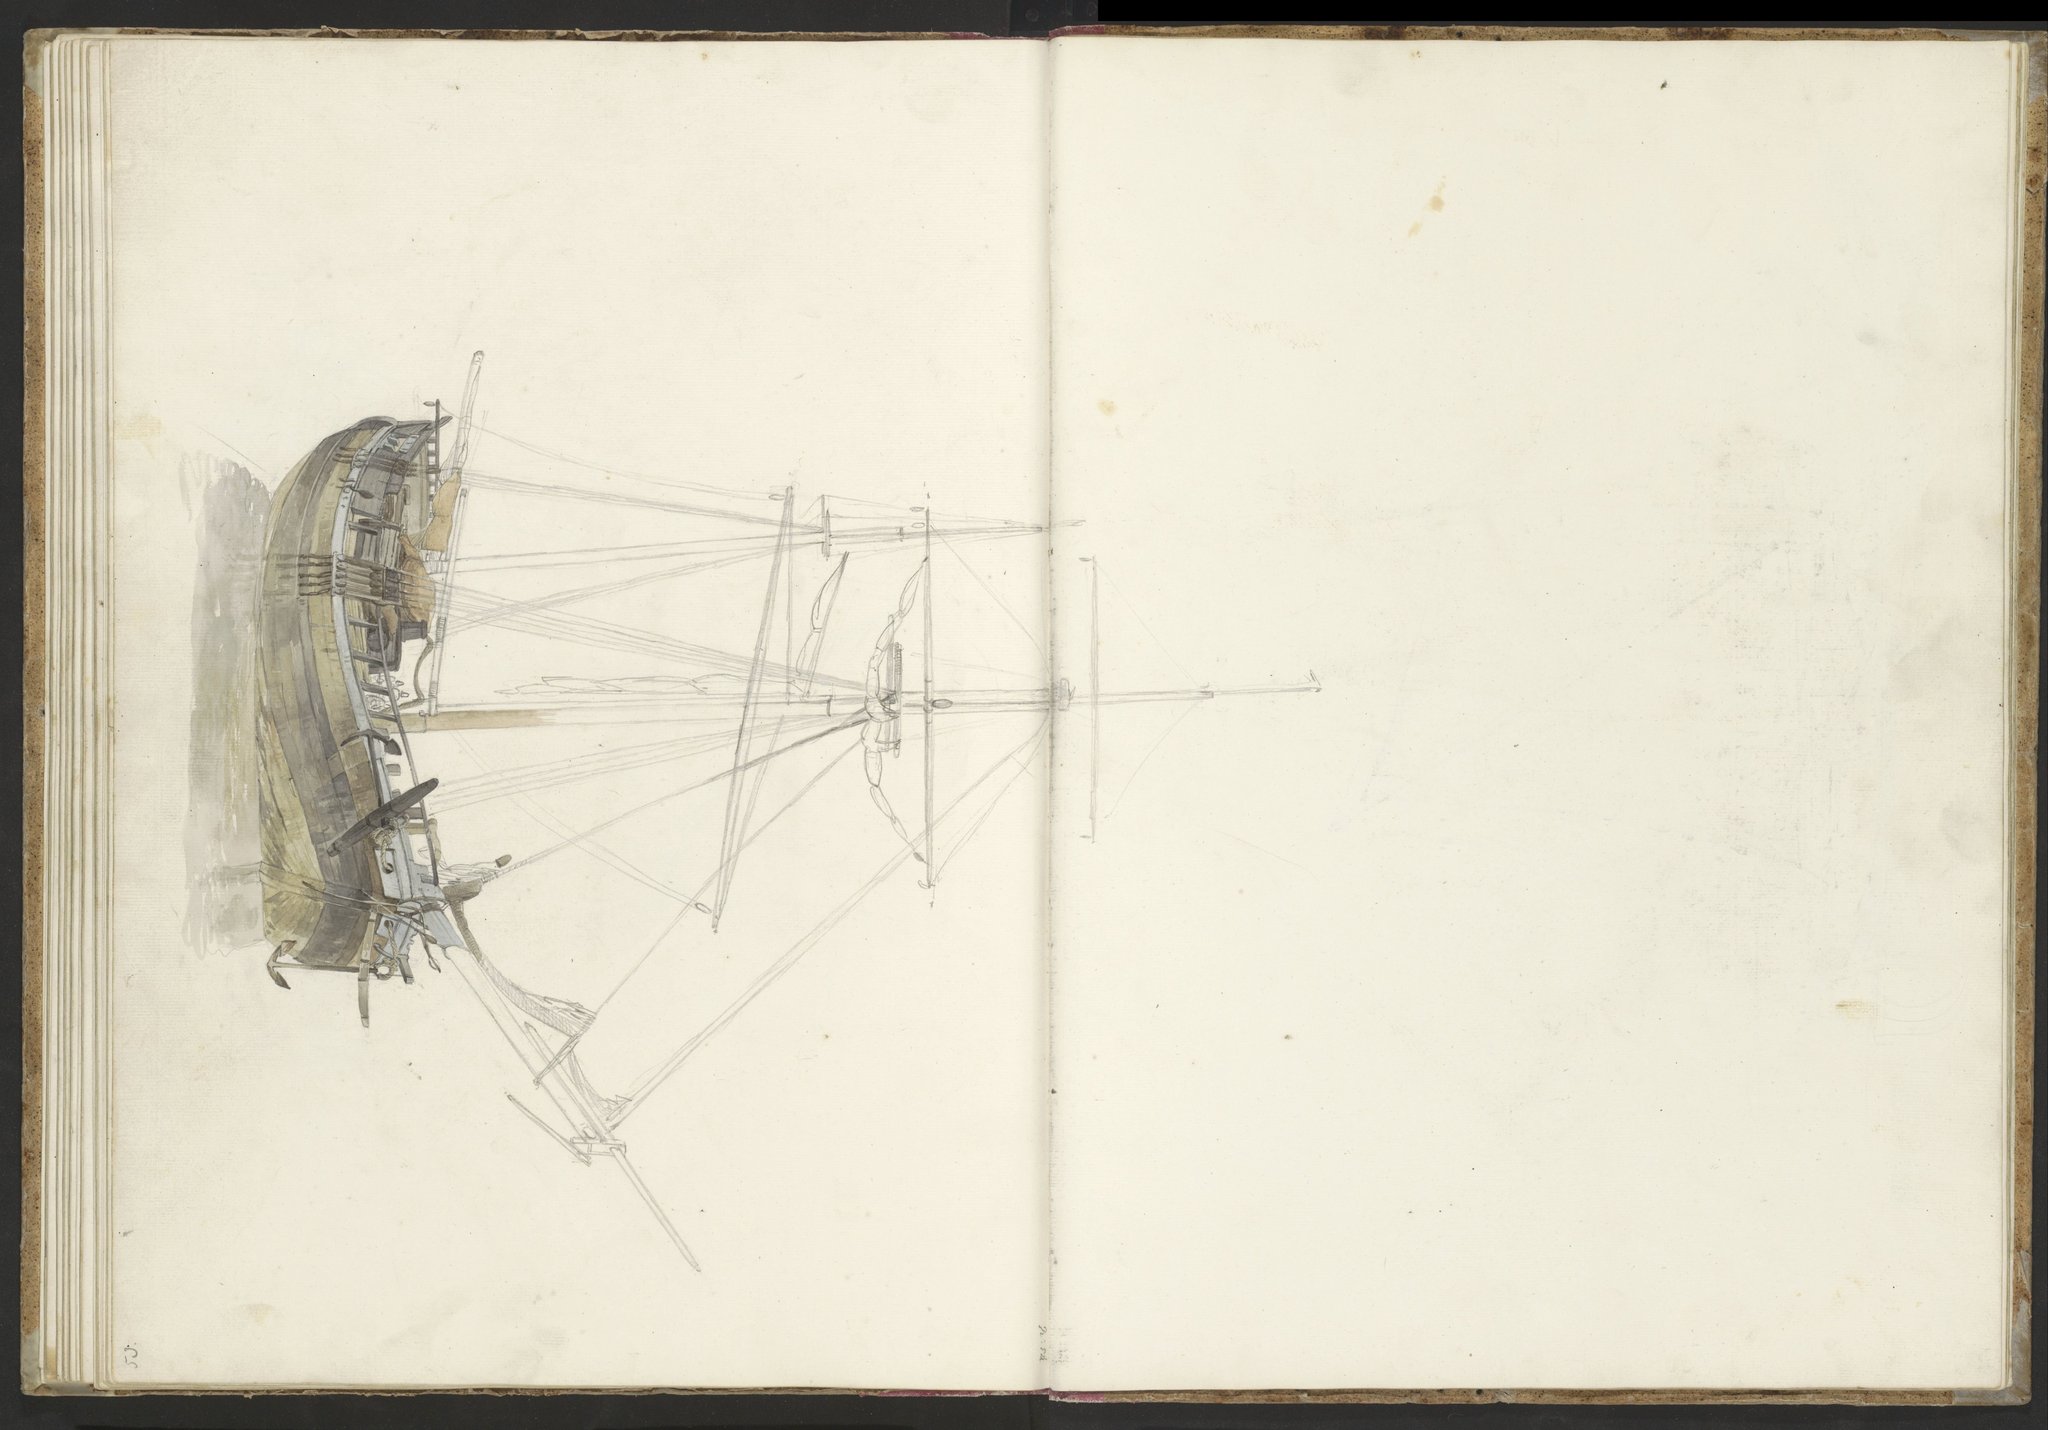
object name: sketchbook leaf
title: Zeilschip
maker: johannes christiaan schotel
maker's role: draughtsman, painter, print maker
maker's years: 1787-1838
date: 1797-1838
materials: paper, pencil, watercolor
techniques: brush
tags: sailing-ship, sailing-boat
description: Blad 53 verso en 54 recto uit een schetsboek met 65 bladen.